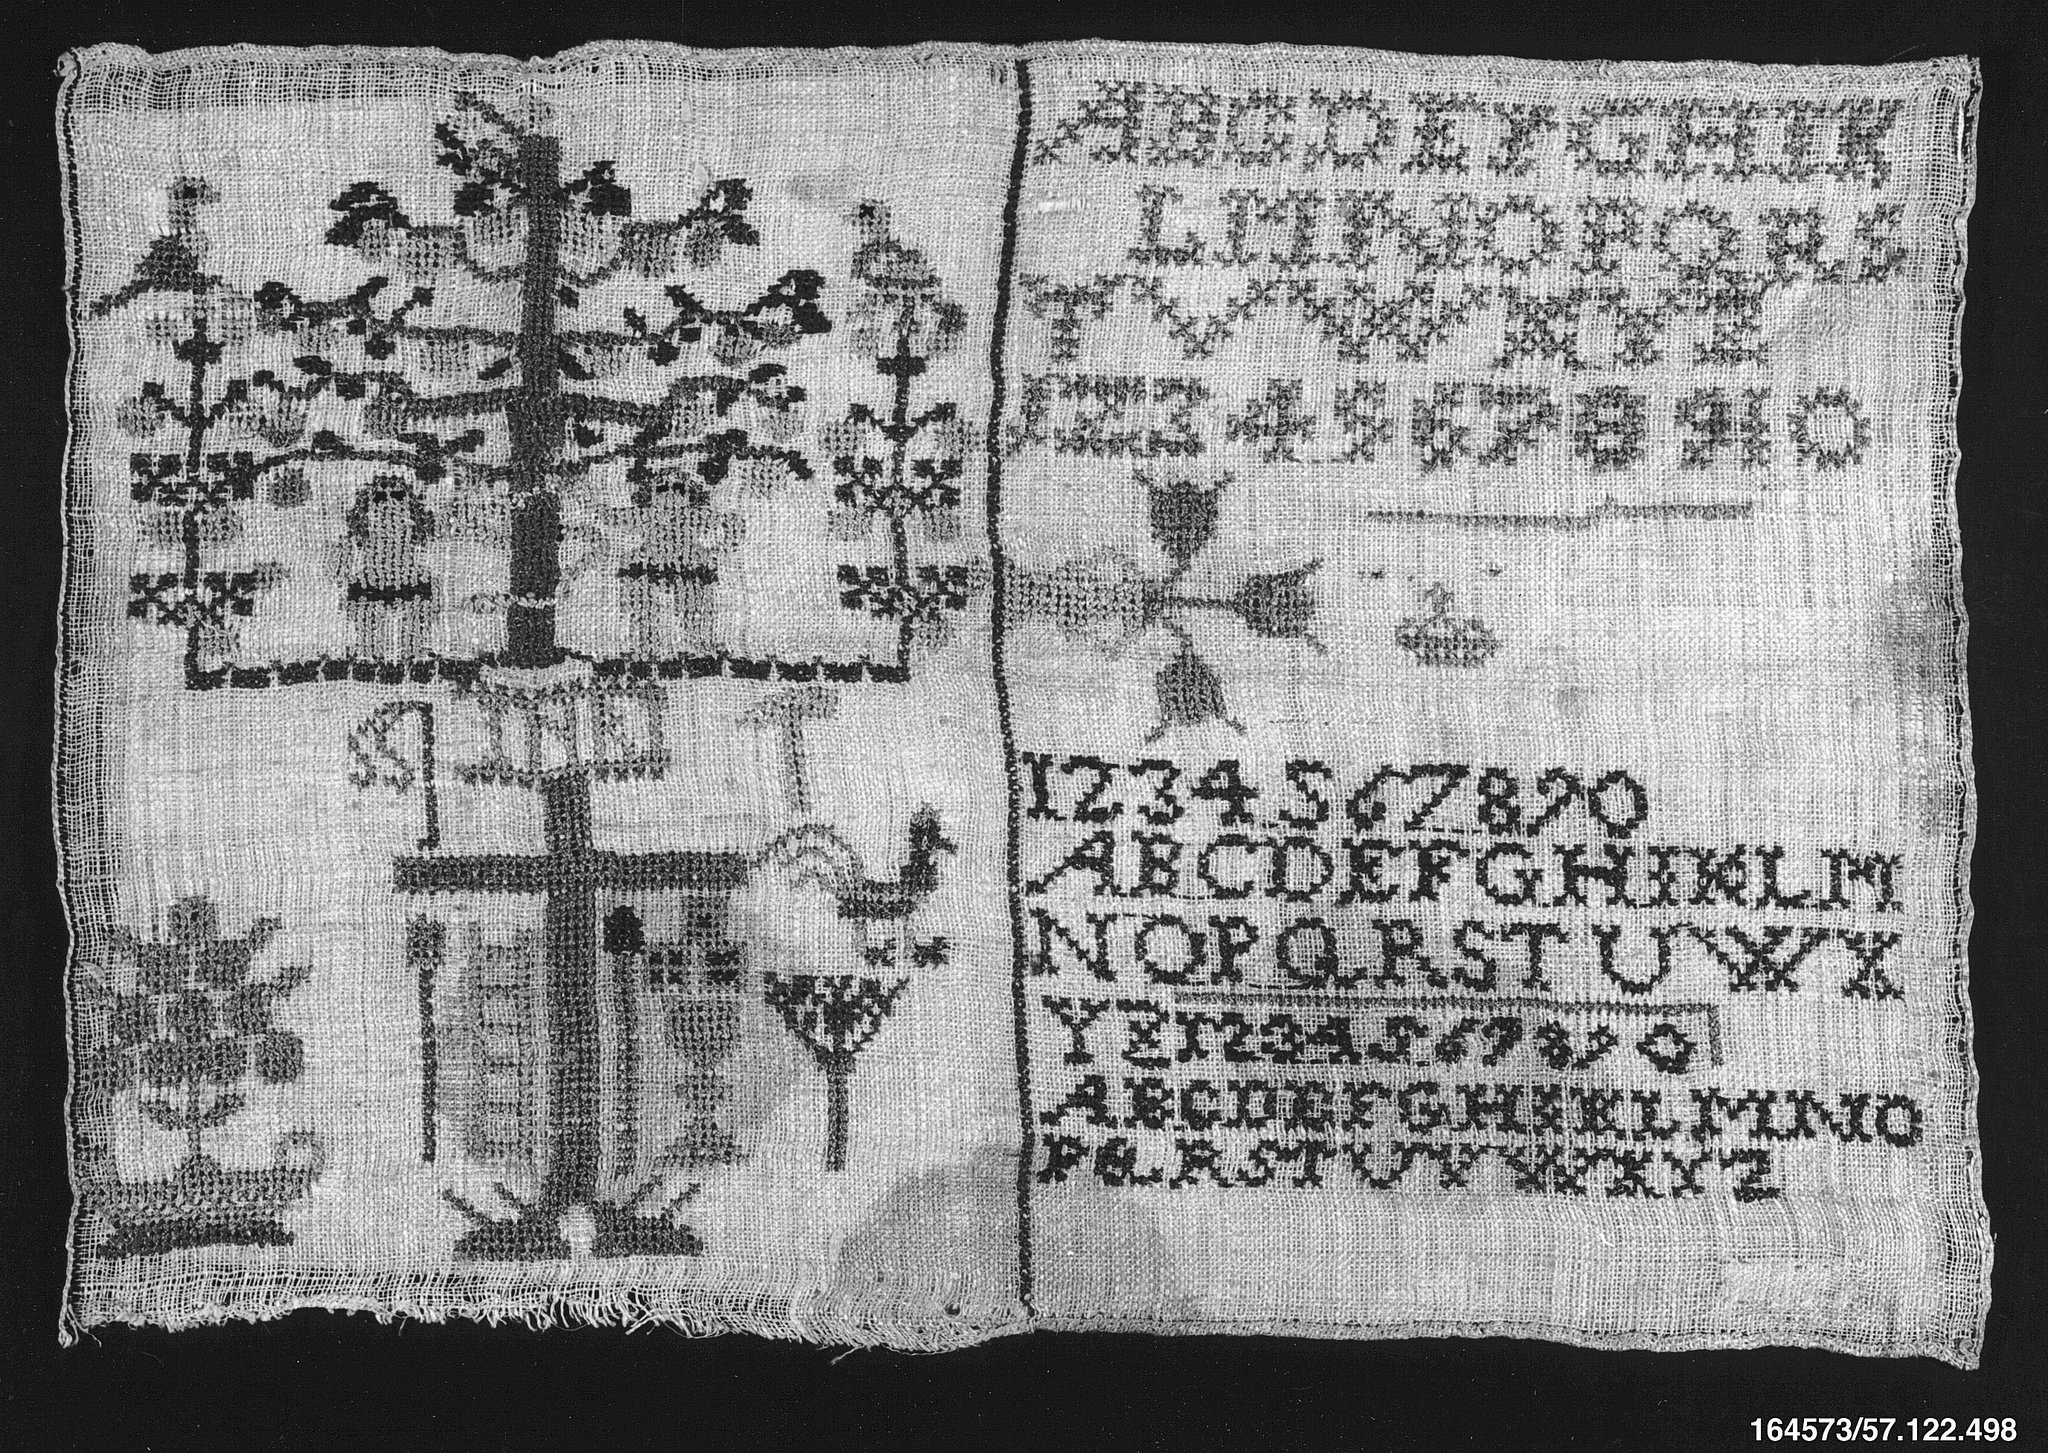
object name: sampler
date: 1801-1900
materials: canvas, cotton, silk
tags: birds,trees